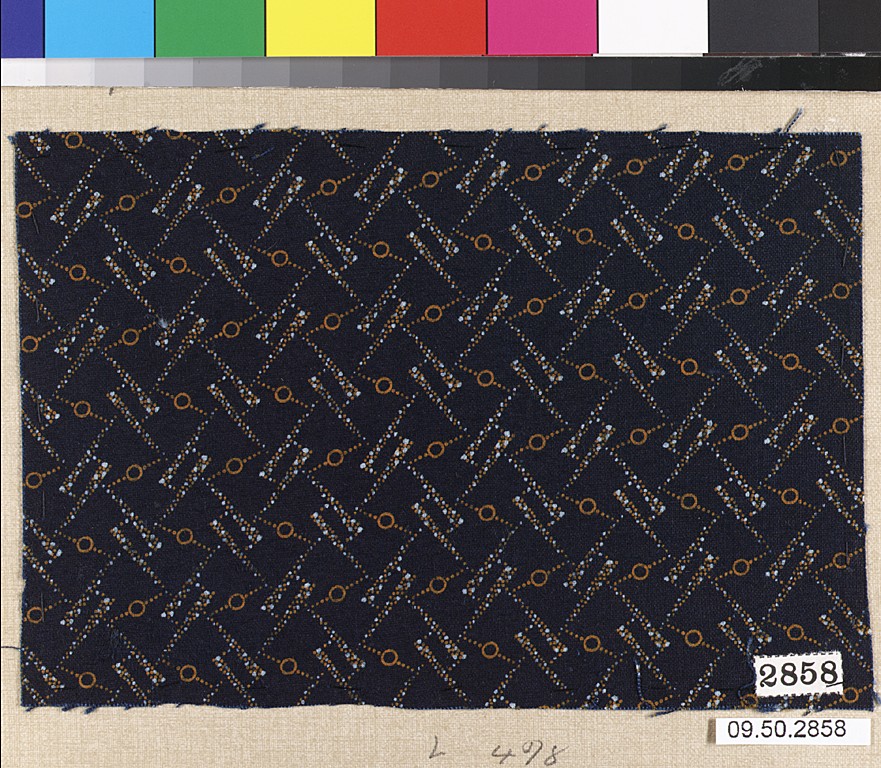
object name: piece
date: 1801-1900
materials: cotton